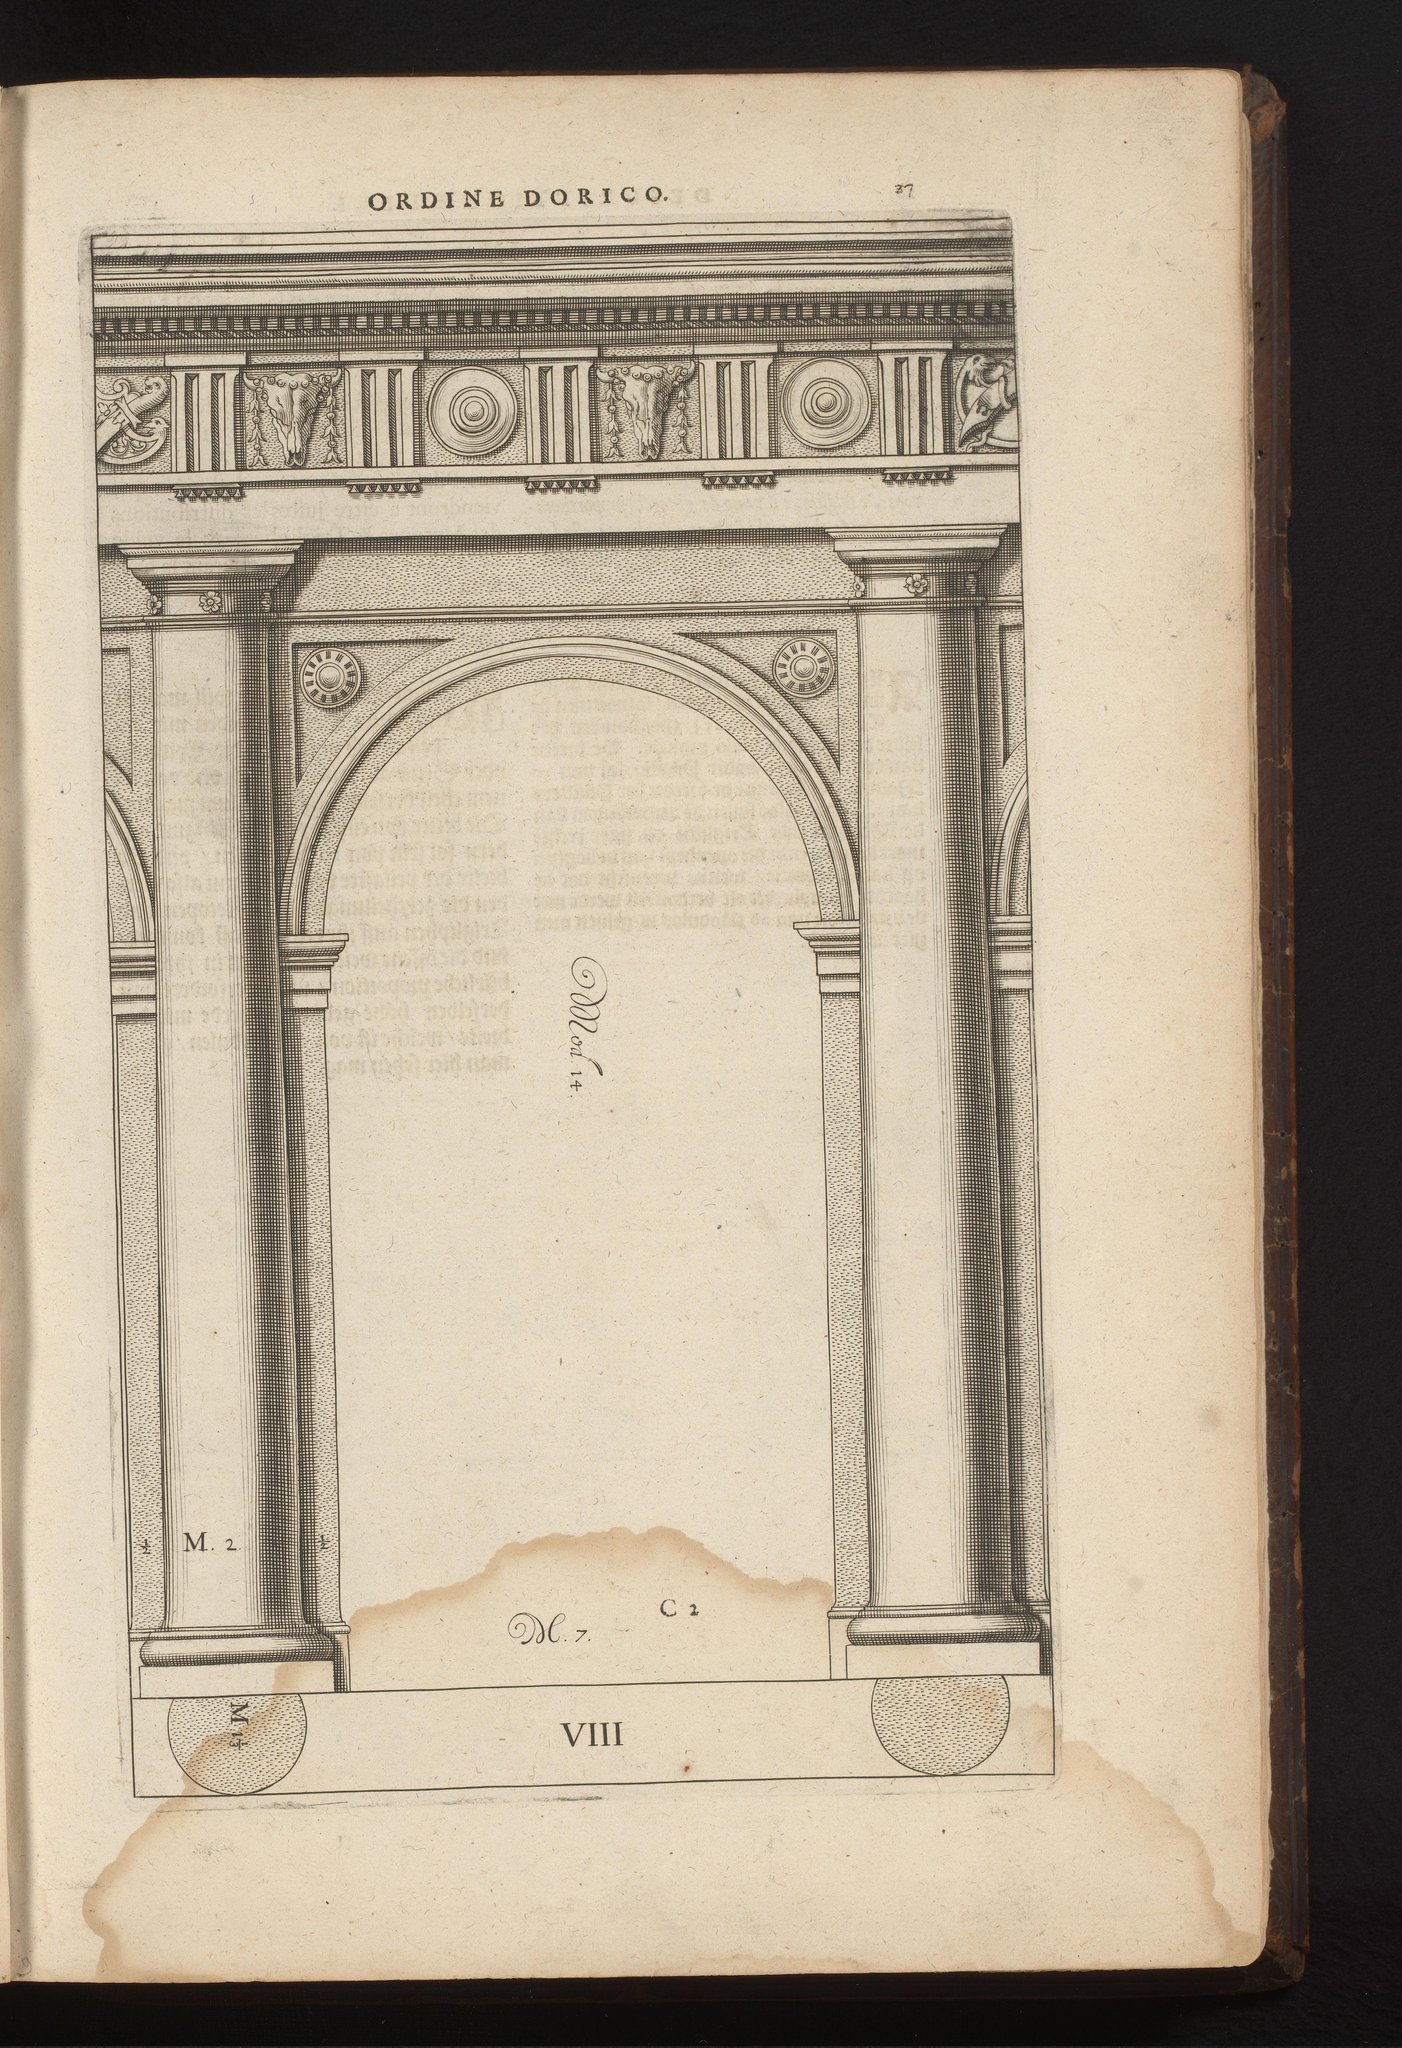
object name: print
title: Dorische zuilen met boog en fundering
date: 1640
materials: paper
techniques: engraving, letterpress printing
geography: amsterdam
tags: doric order ~ architecture, orders, order-books ~ architecture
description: Prent uit: Vignola, Giacomo Barozzi da. Regola delli cinque ordini d'architettura (...). Amsterdam: Johannes Willemszoon en Cornelis Blaeu, 1640, p. 27.